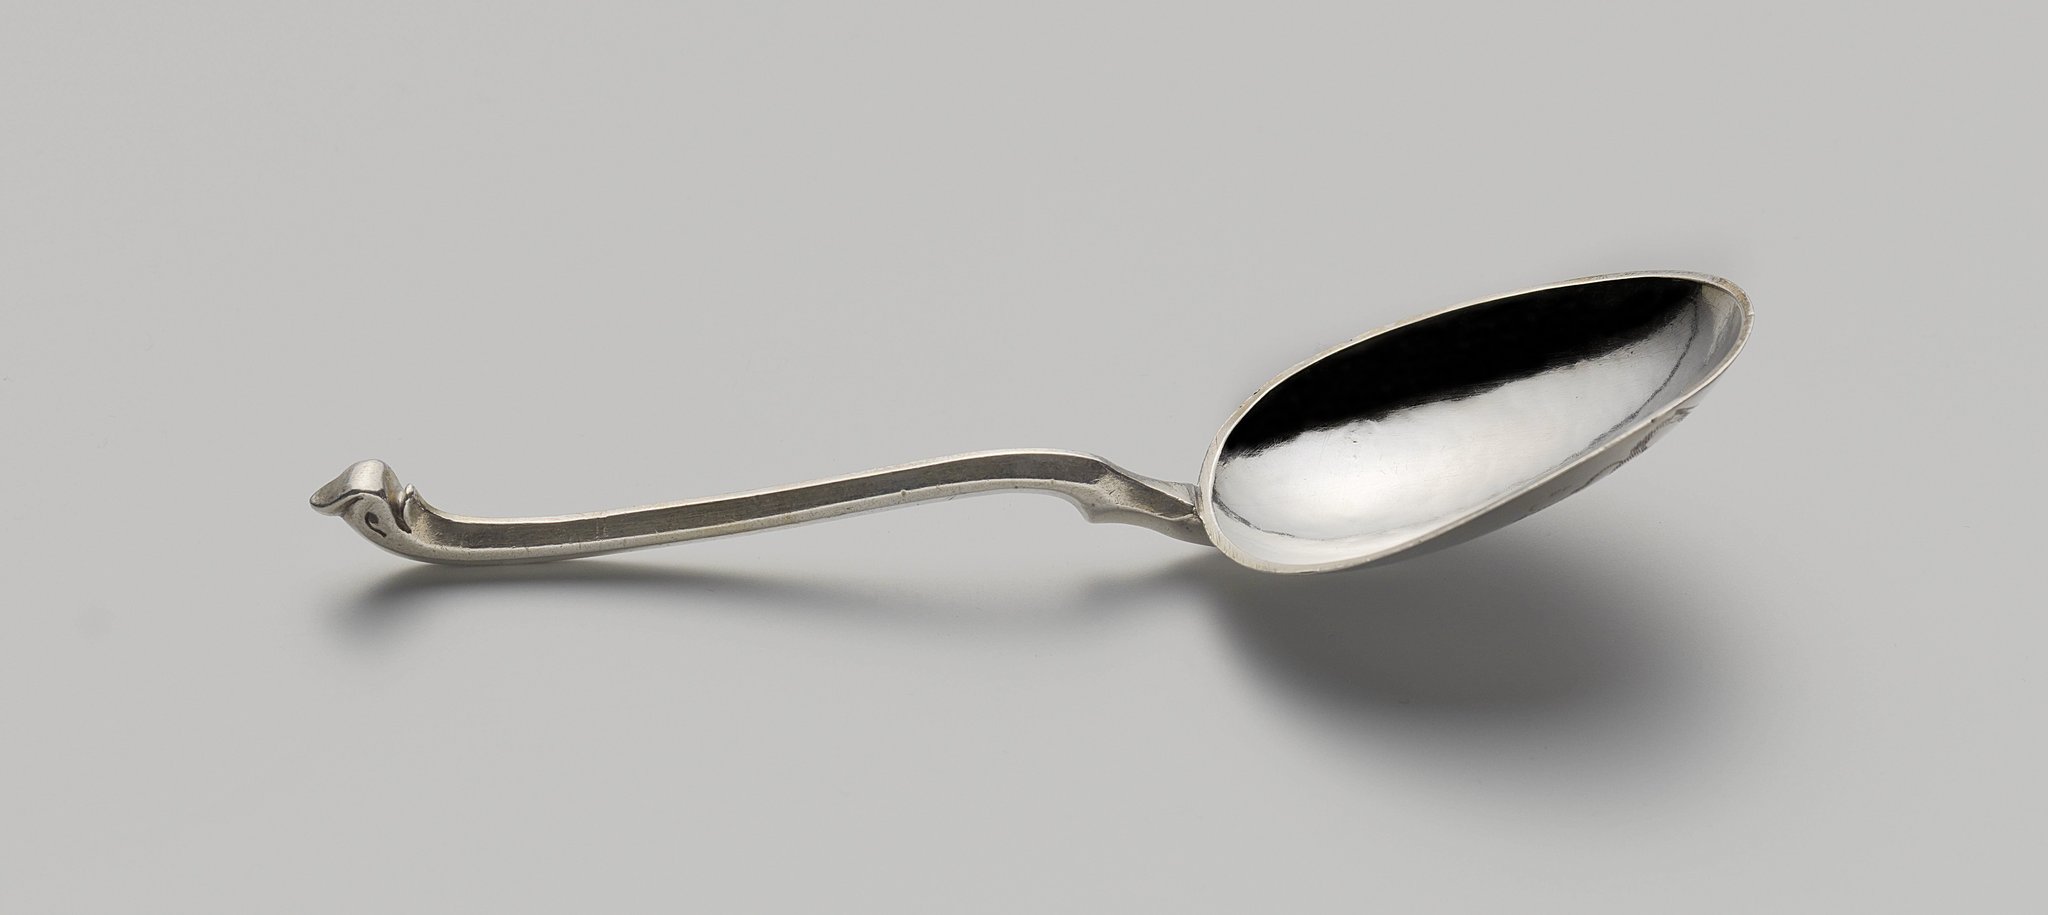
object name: spoon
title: Lepel met op de achterzijde van de ovale bak het wapen van Amsterdam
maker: Anonymous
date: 1658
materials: silver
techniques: engraving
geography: amsterdam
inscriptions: maker's mark: ‘M (Voet 1912, nr, 91; Citroen 1975, nr. 667).’, town mark, date letter: ‘F’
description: De ovale bak is door middel van een naald verbonden met de gefacetteerde, bij de aanzet en het uiteinde gebogen steel, die eindigt in een gestileerde dierenkop. Op de onderzijde van de bak is het gekroonde wapen van Amsterdam gehouden door leeuwen gegraveerd.